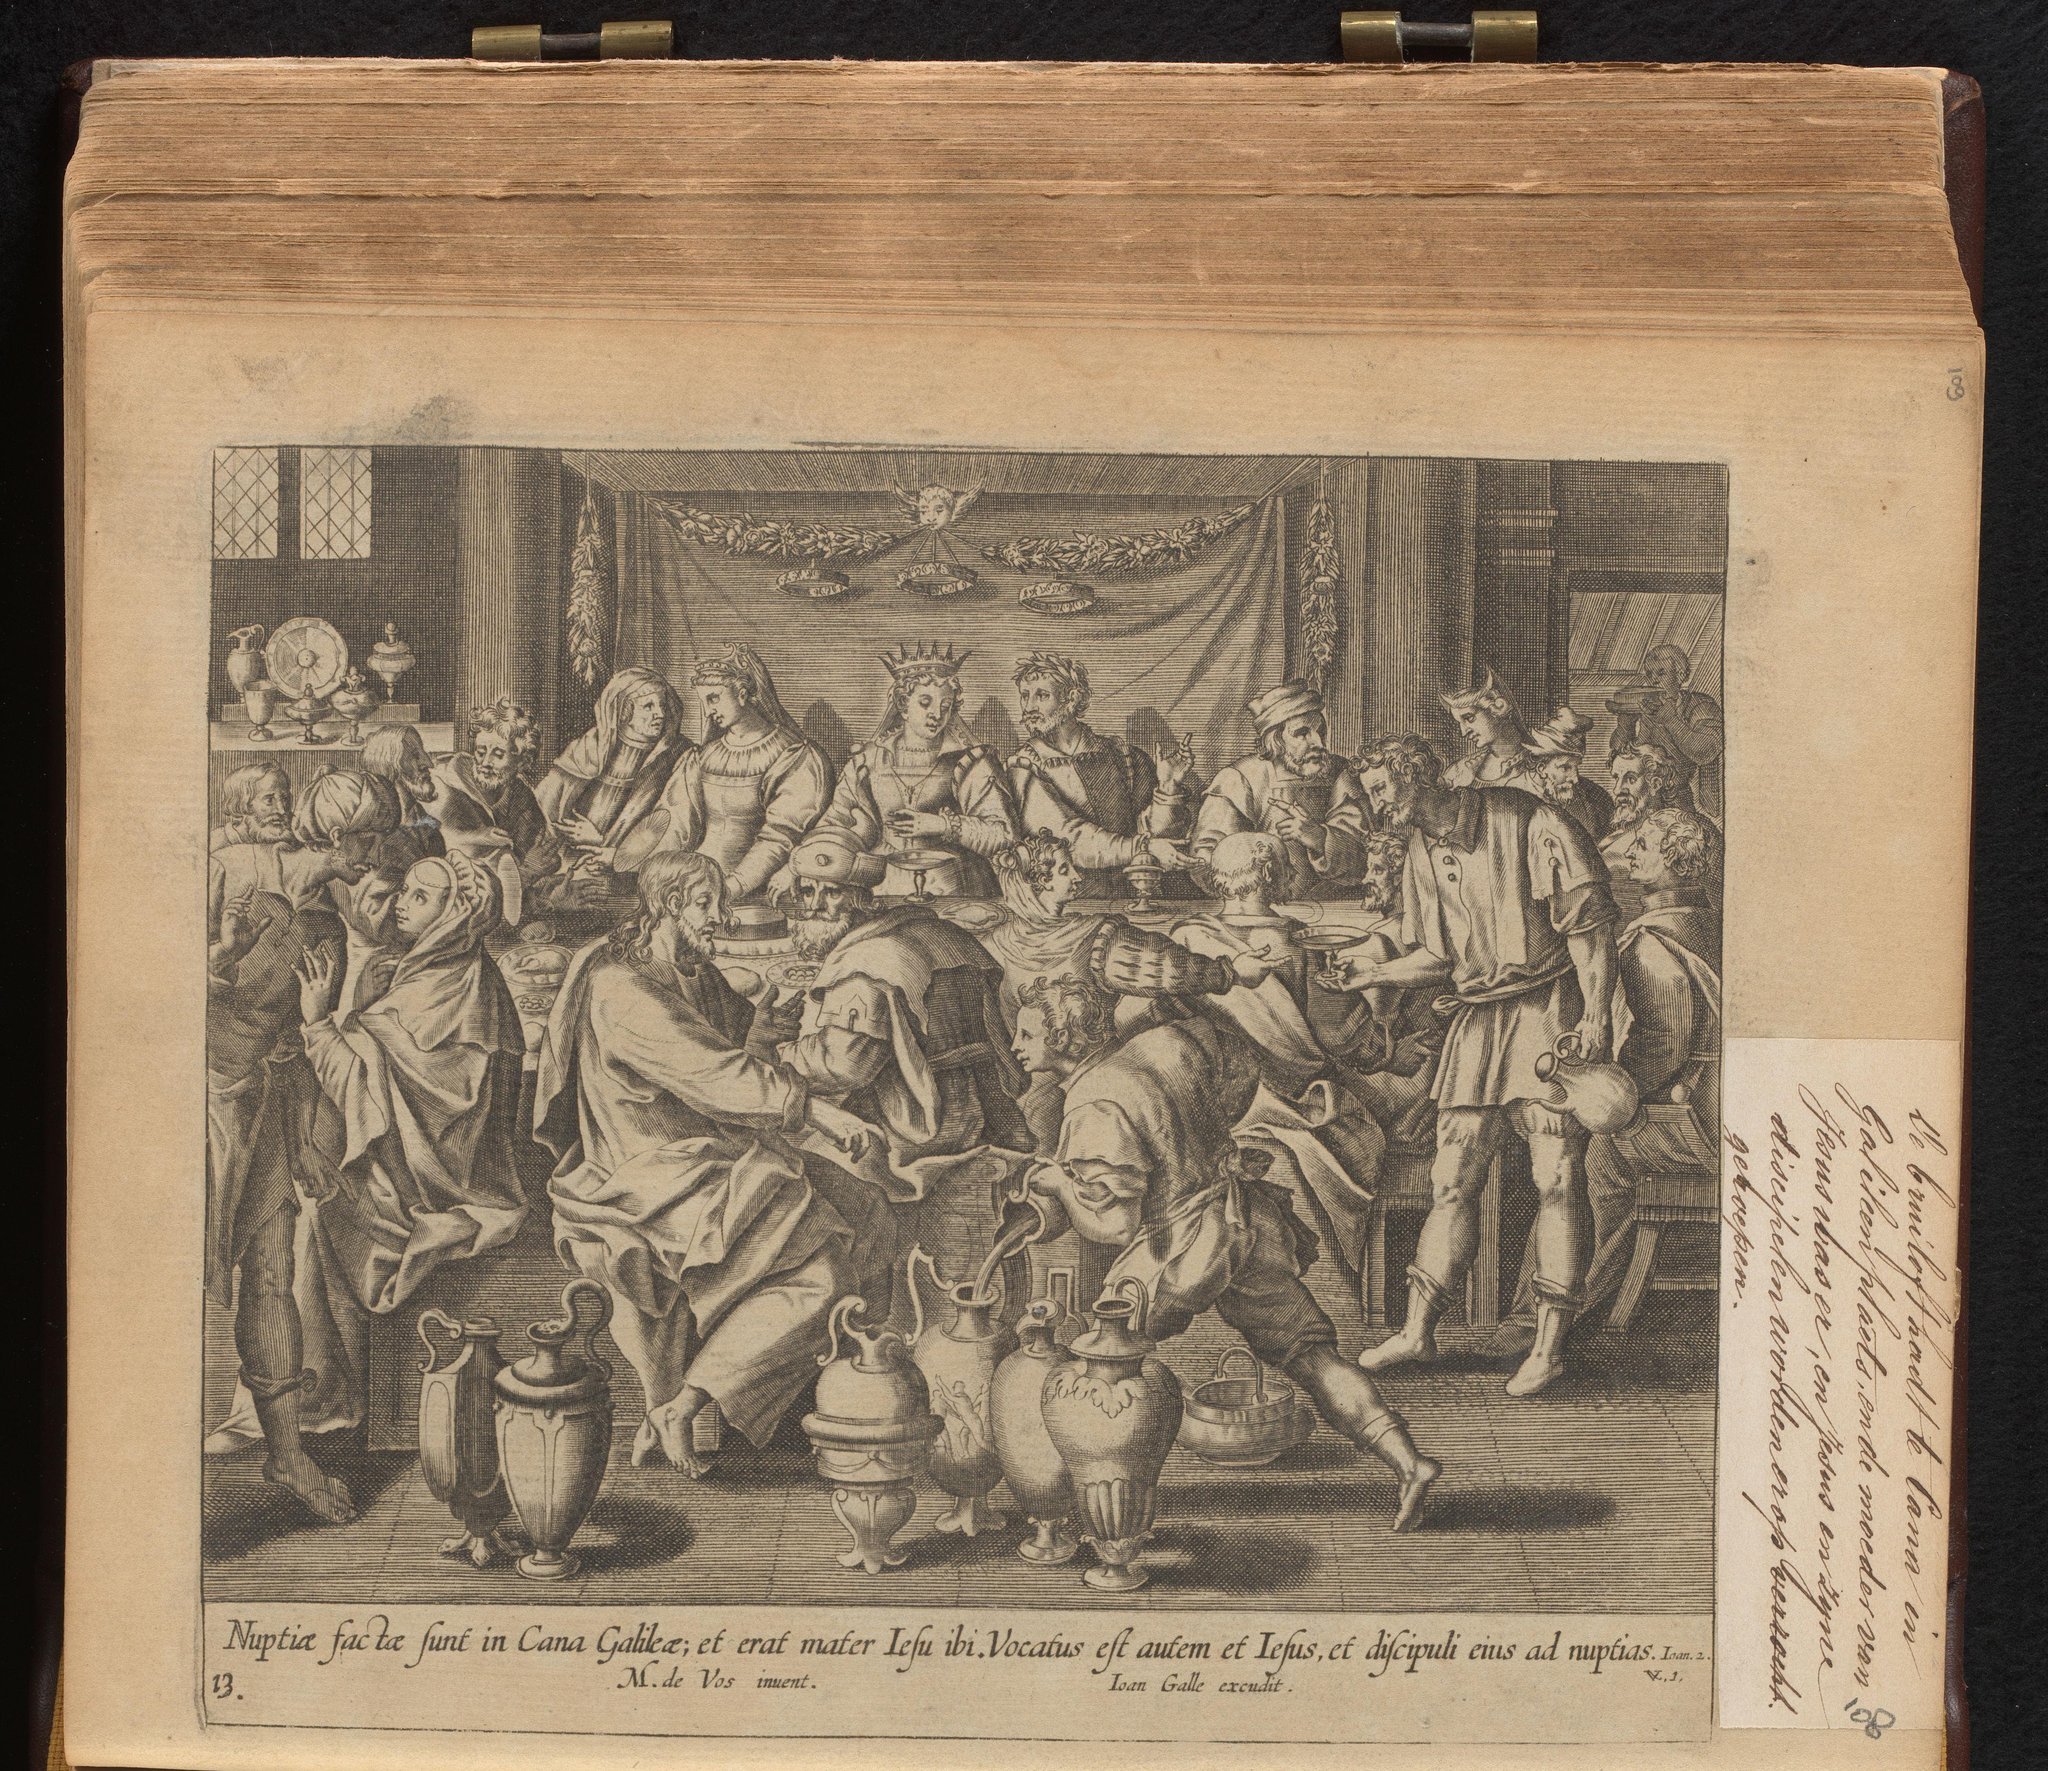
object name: album leaf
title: Leven, passie en wederopstanding van Christus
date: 1598-1618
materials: paper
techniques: engraving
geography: antwerp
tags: the marriage-feast at cana (john 2:1-11)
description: Prent maakt deel uit van een prentbijbel.